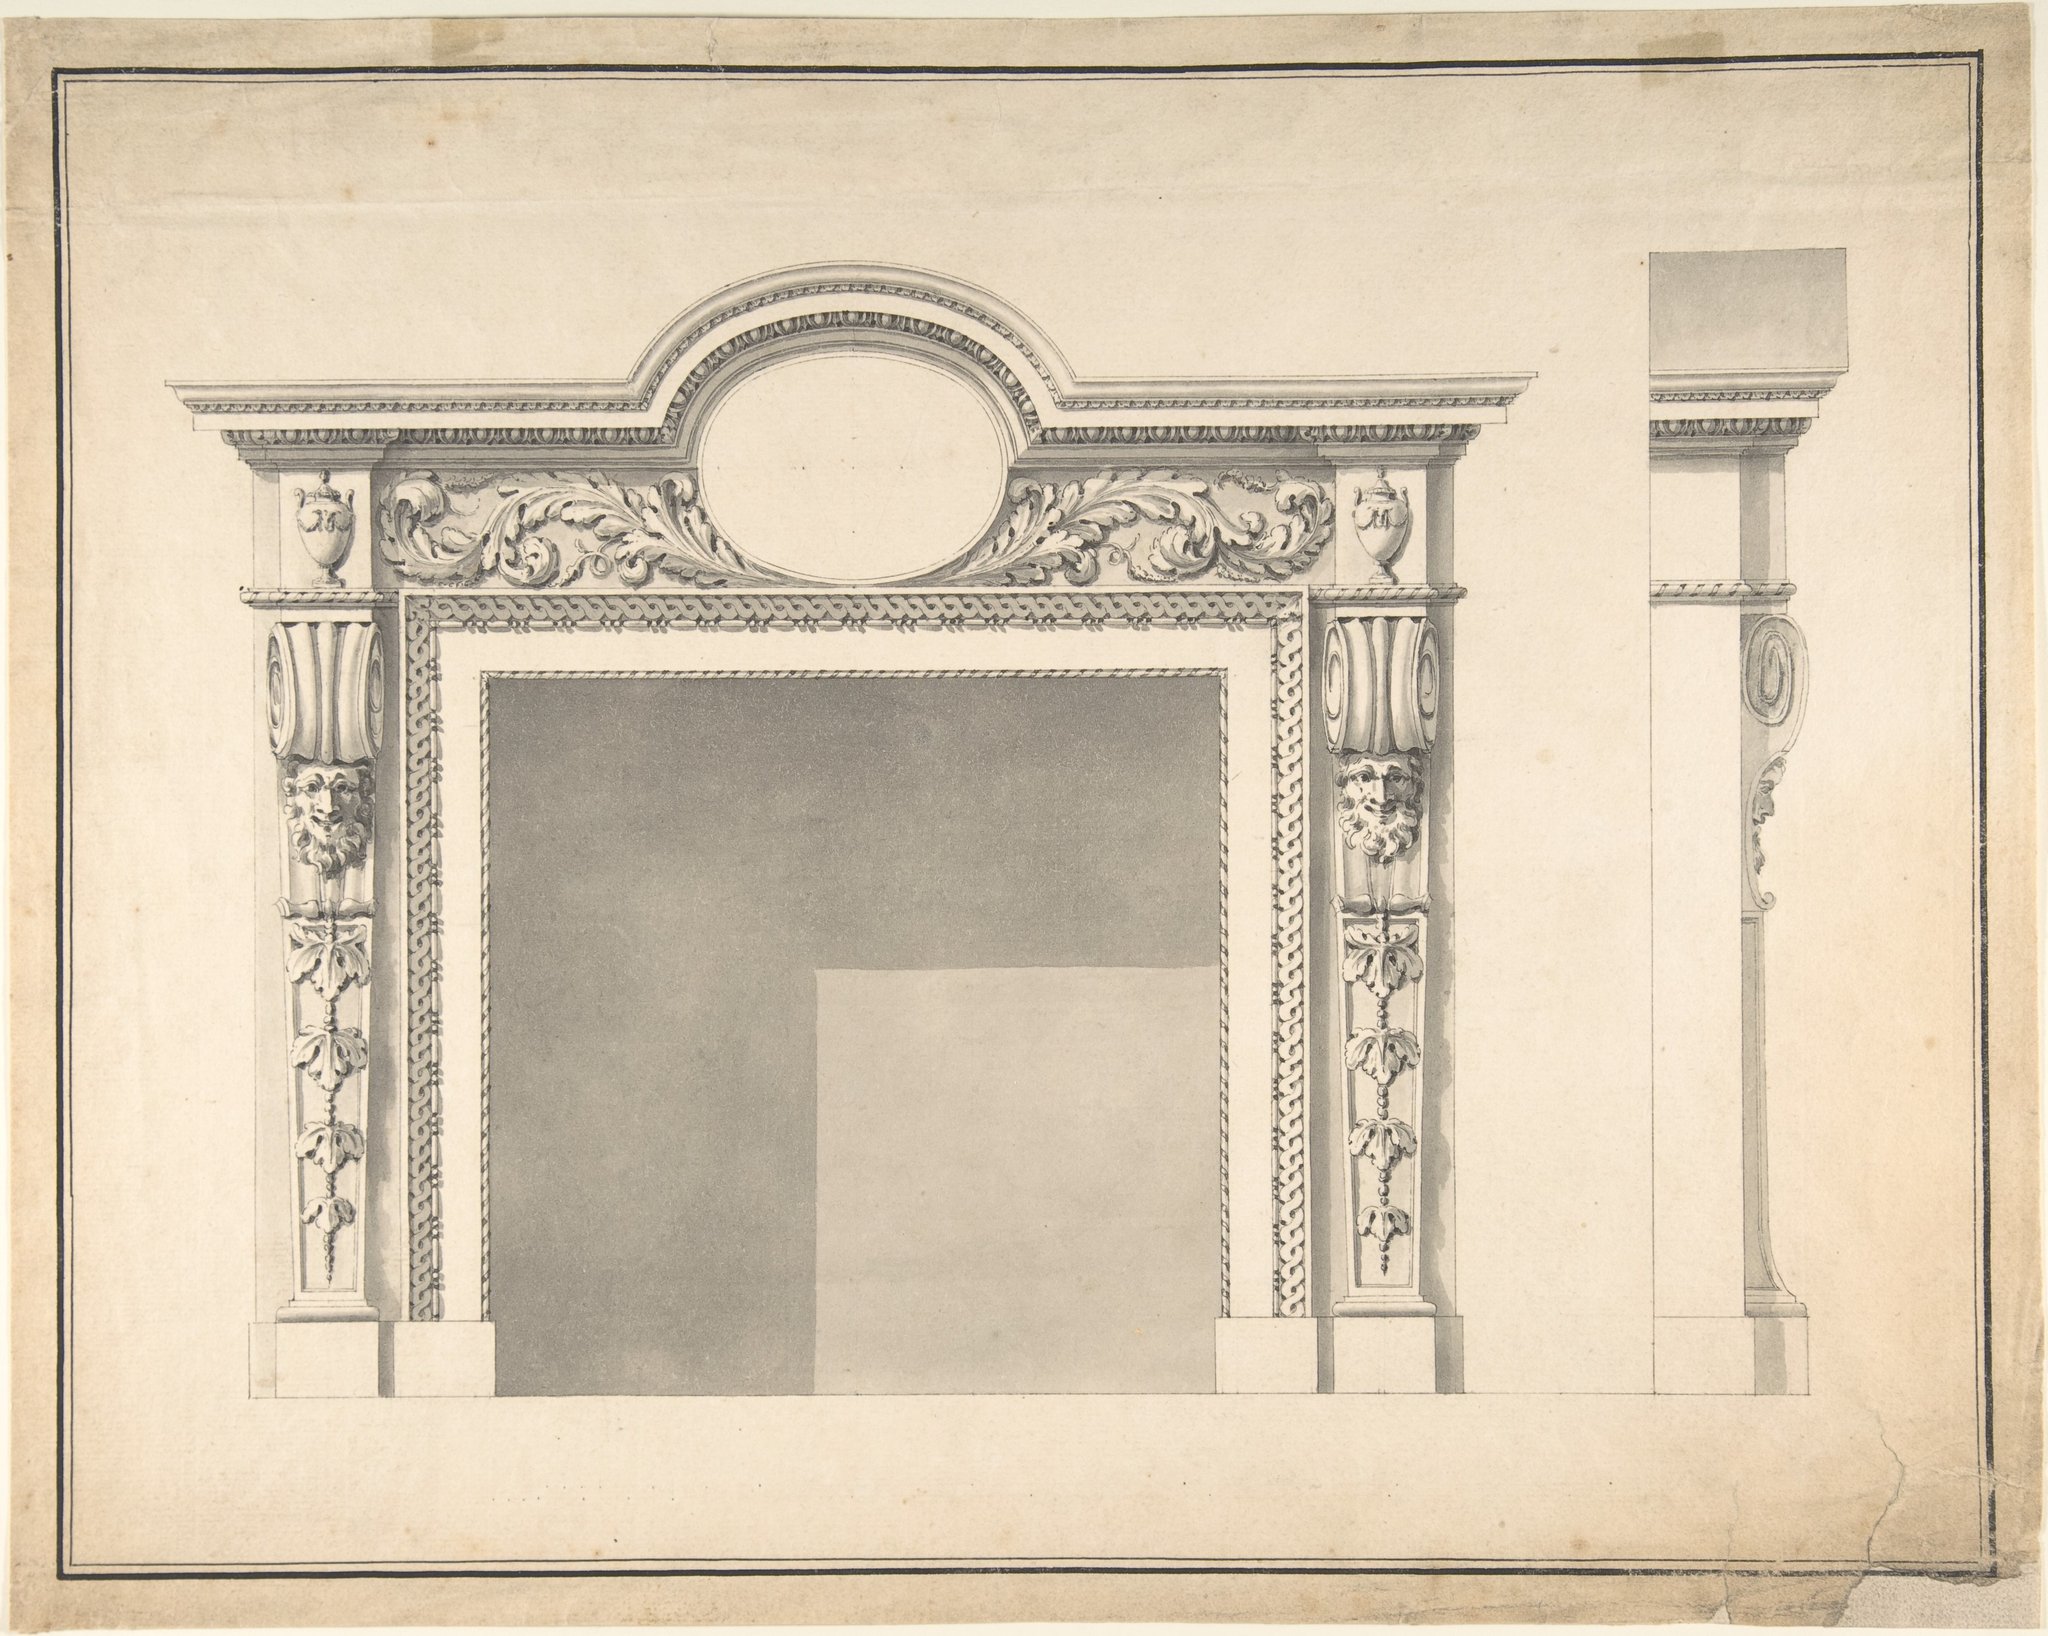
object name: drawing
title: Design for a Fireplace with Frontal and Profile Views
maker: james stuart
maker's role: artist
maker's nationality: british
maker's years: 1713-1788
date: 1735-1788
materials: ink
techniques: brush, pen, wash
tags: fireplaces